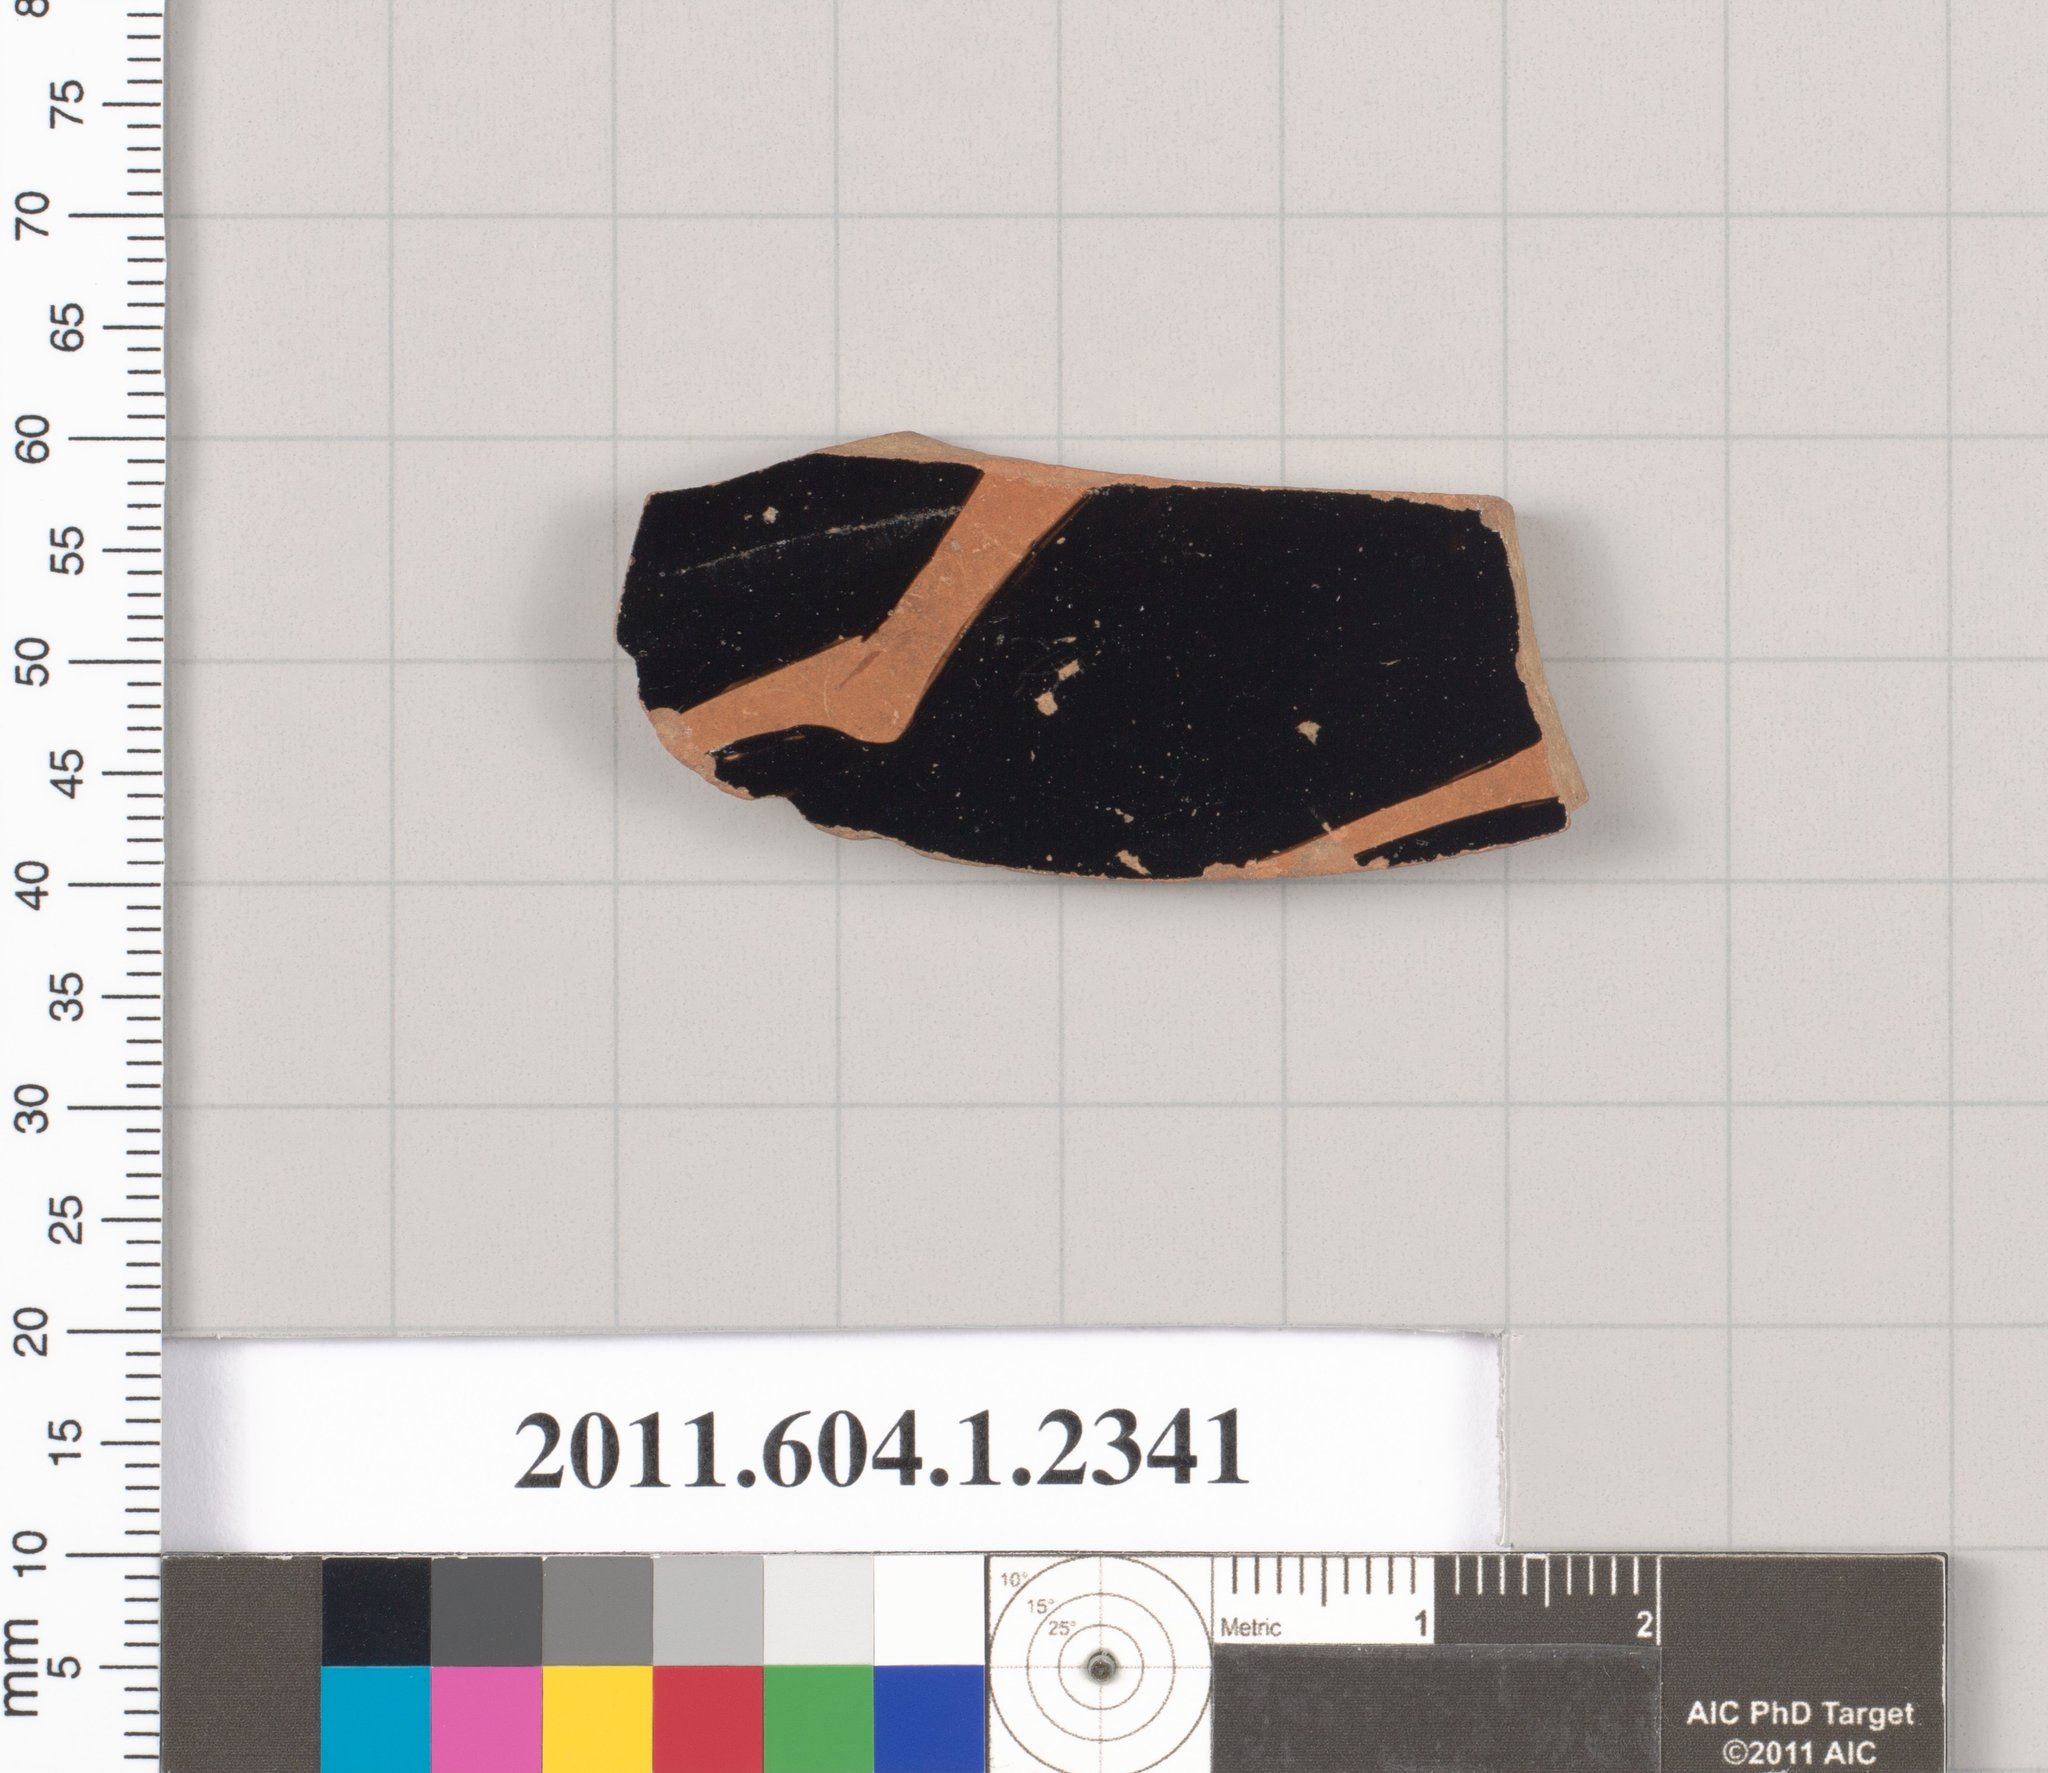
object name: kylix fragment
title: Terracotta fragment of a kylix (drinking cup)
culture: greek, attic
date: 475-451 BCE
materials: terracotta